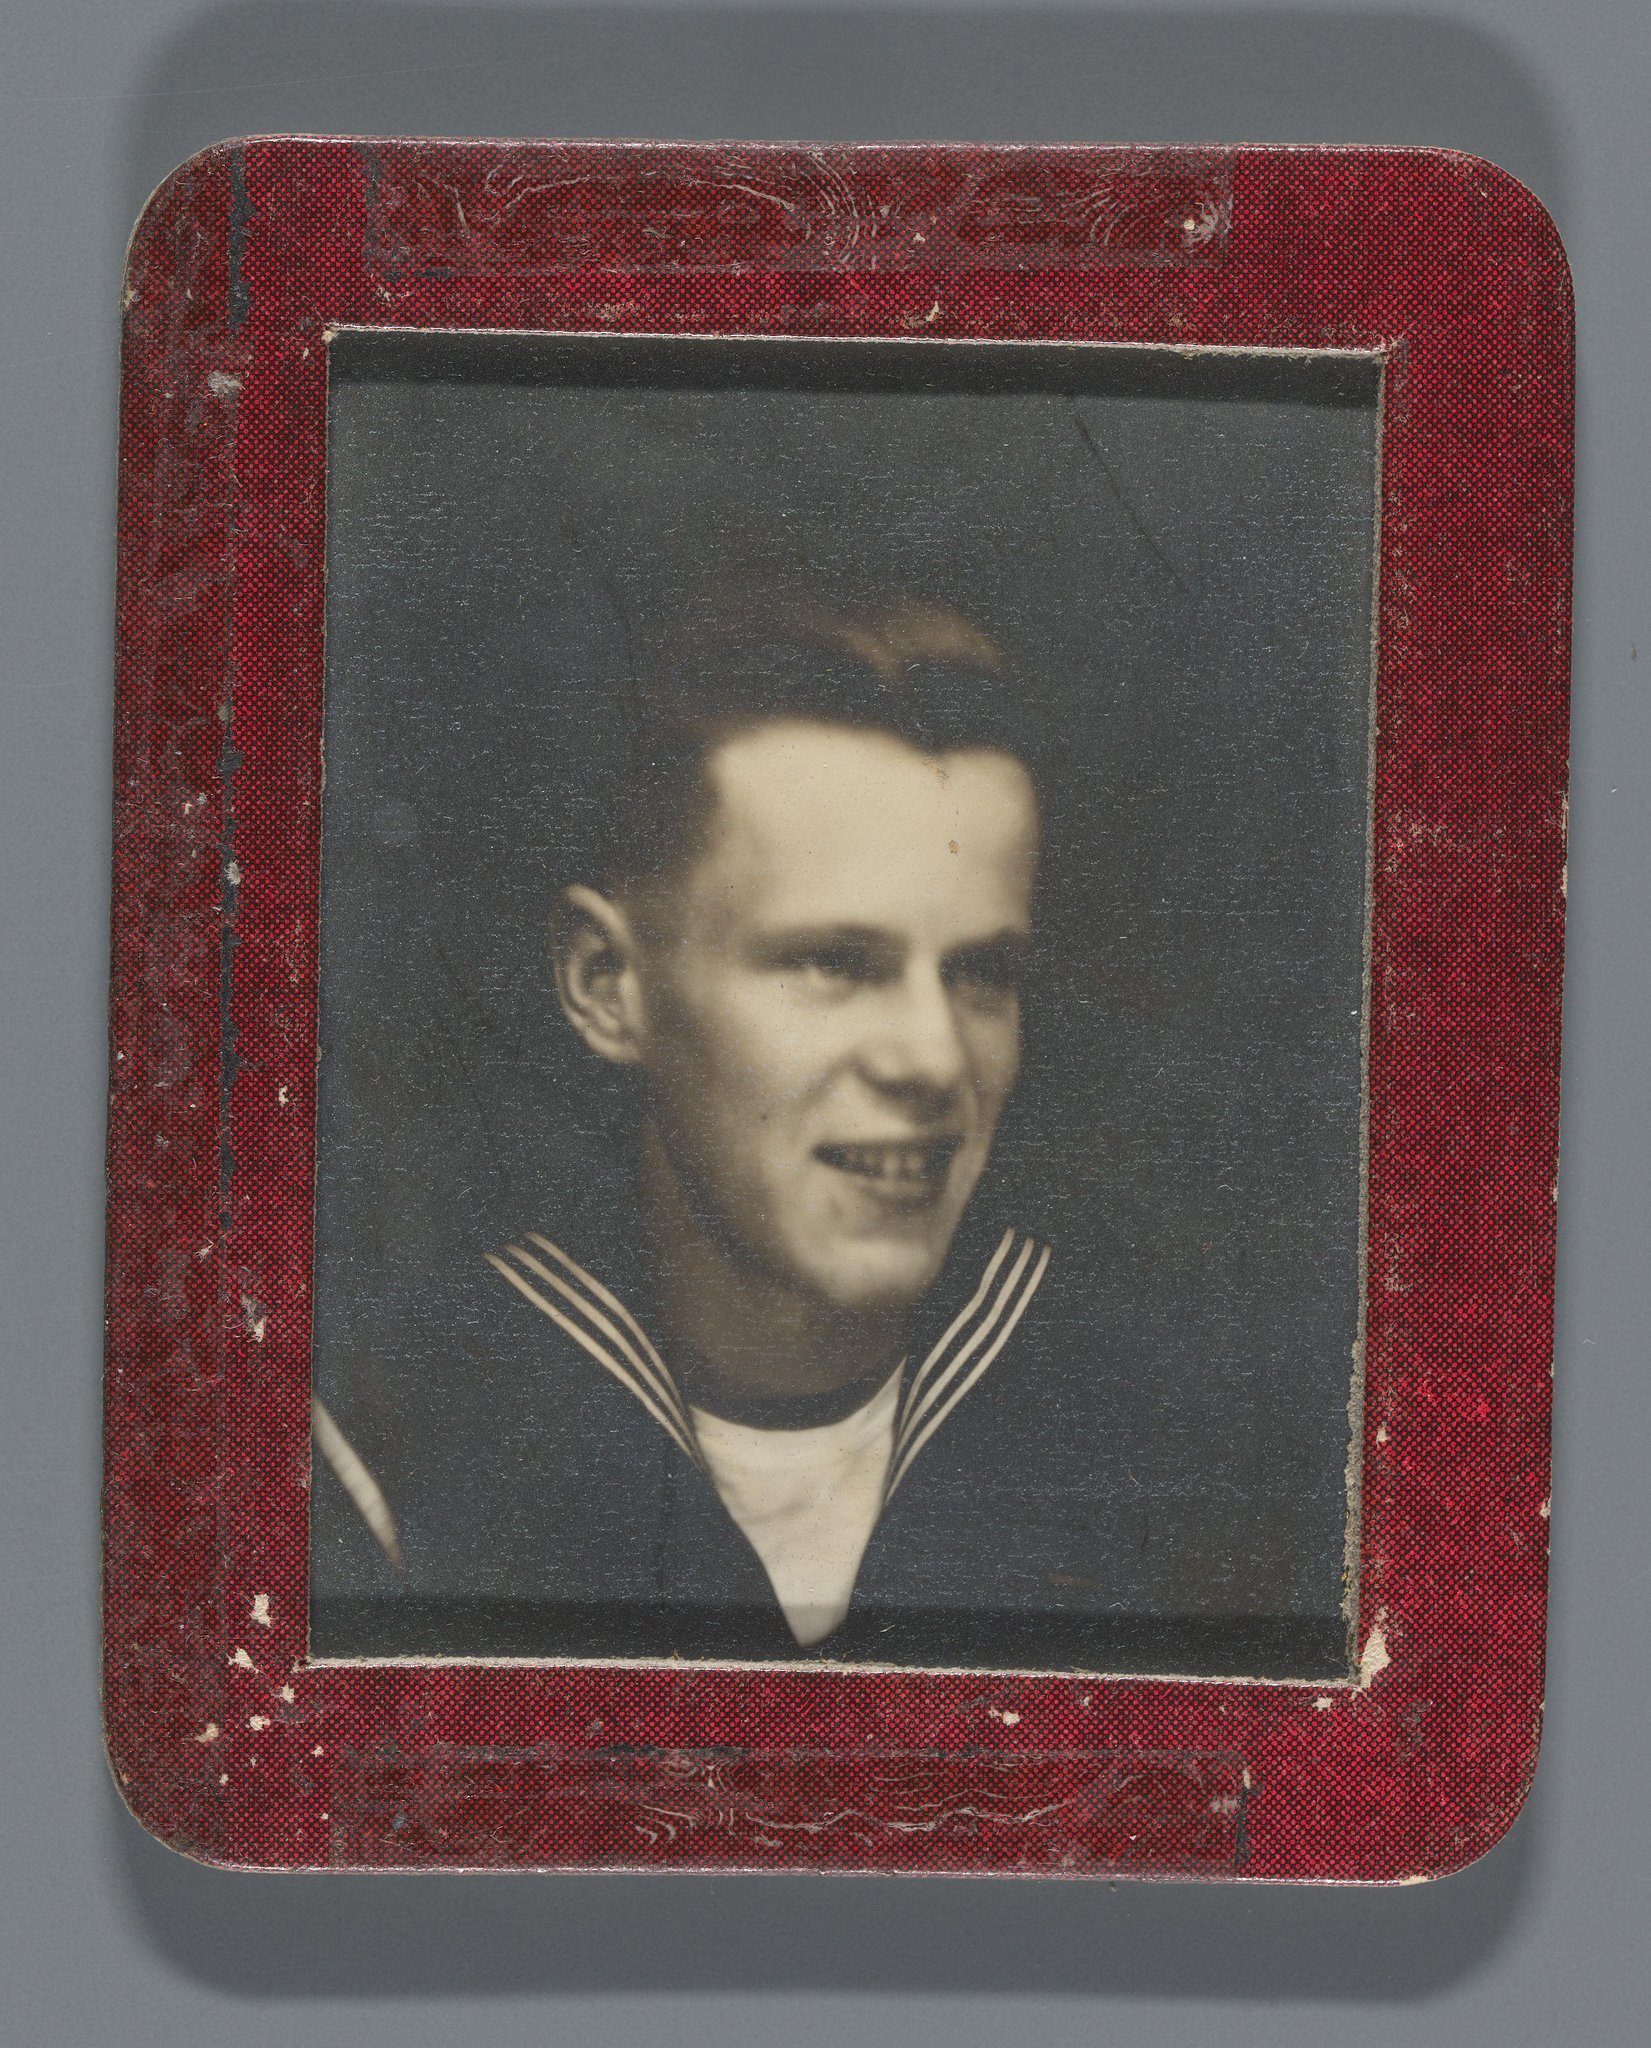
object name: photograph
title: William Swanson, matroos, 1944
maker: Anonymous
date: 1944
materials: photographic support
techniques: gelatin silver print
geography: united states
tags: militair, william swanson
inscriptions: inscription: ‘Buffalo October 5, 1944’, inscription: ‘PHOTOFRAME / T.M. REG U.S. PSAT. OFF. / PATENT PENDING / Taken by the Photomatic / T.M. REG. U.S. PSAT. OFF. / SEE PATENTS LISTED ON / OUR DAYLIGHT LOADING MAGAZINE / MADE IN U.S.A. / INTERNATIONAL MUTOSCOPE / CORPORATION / NEW YORK CITY’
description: Photomatic, portret zonder hoofddeksel naar rechts.